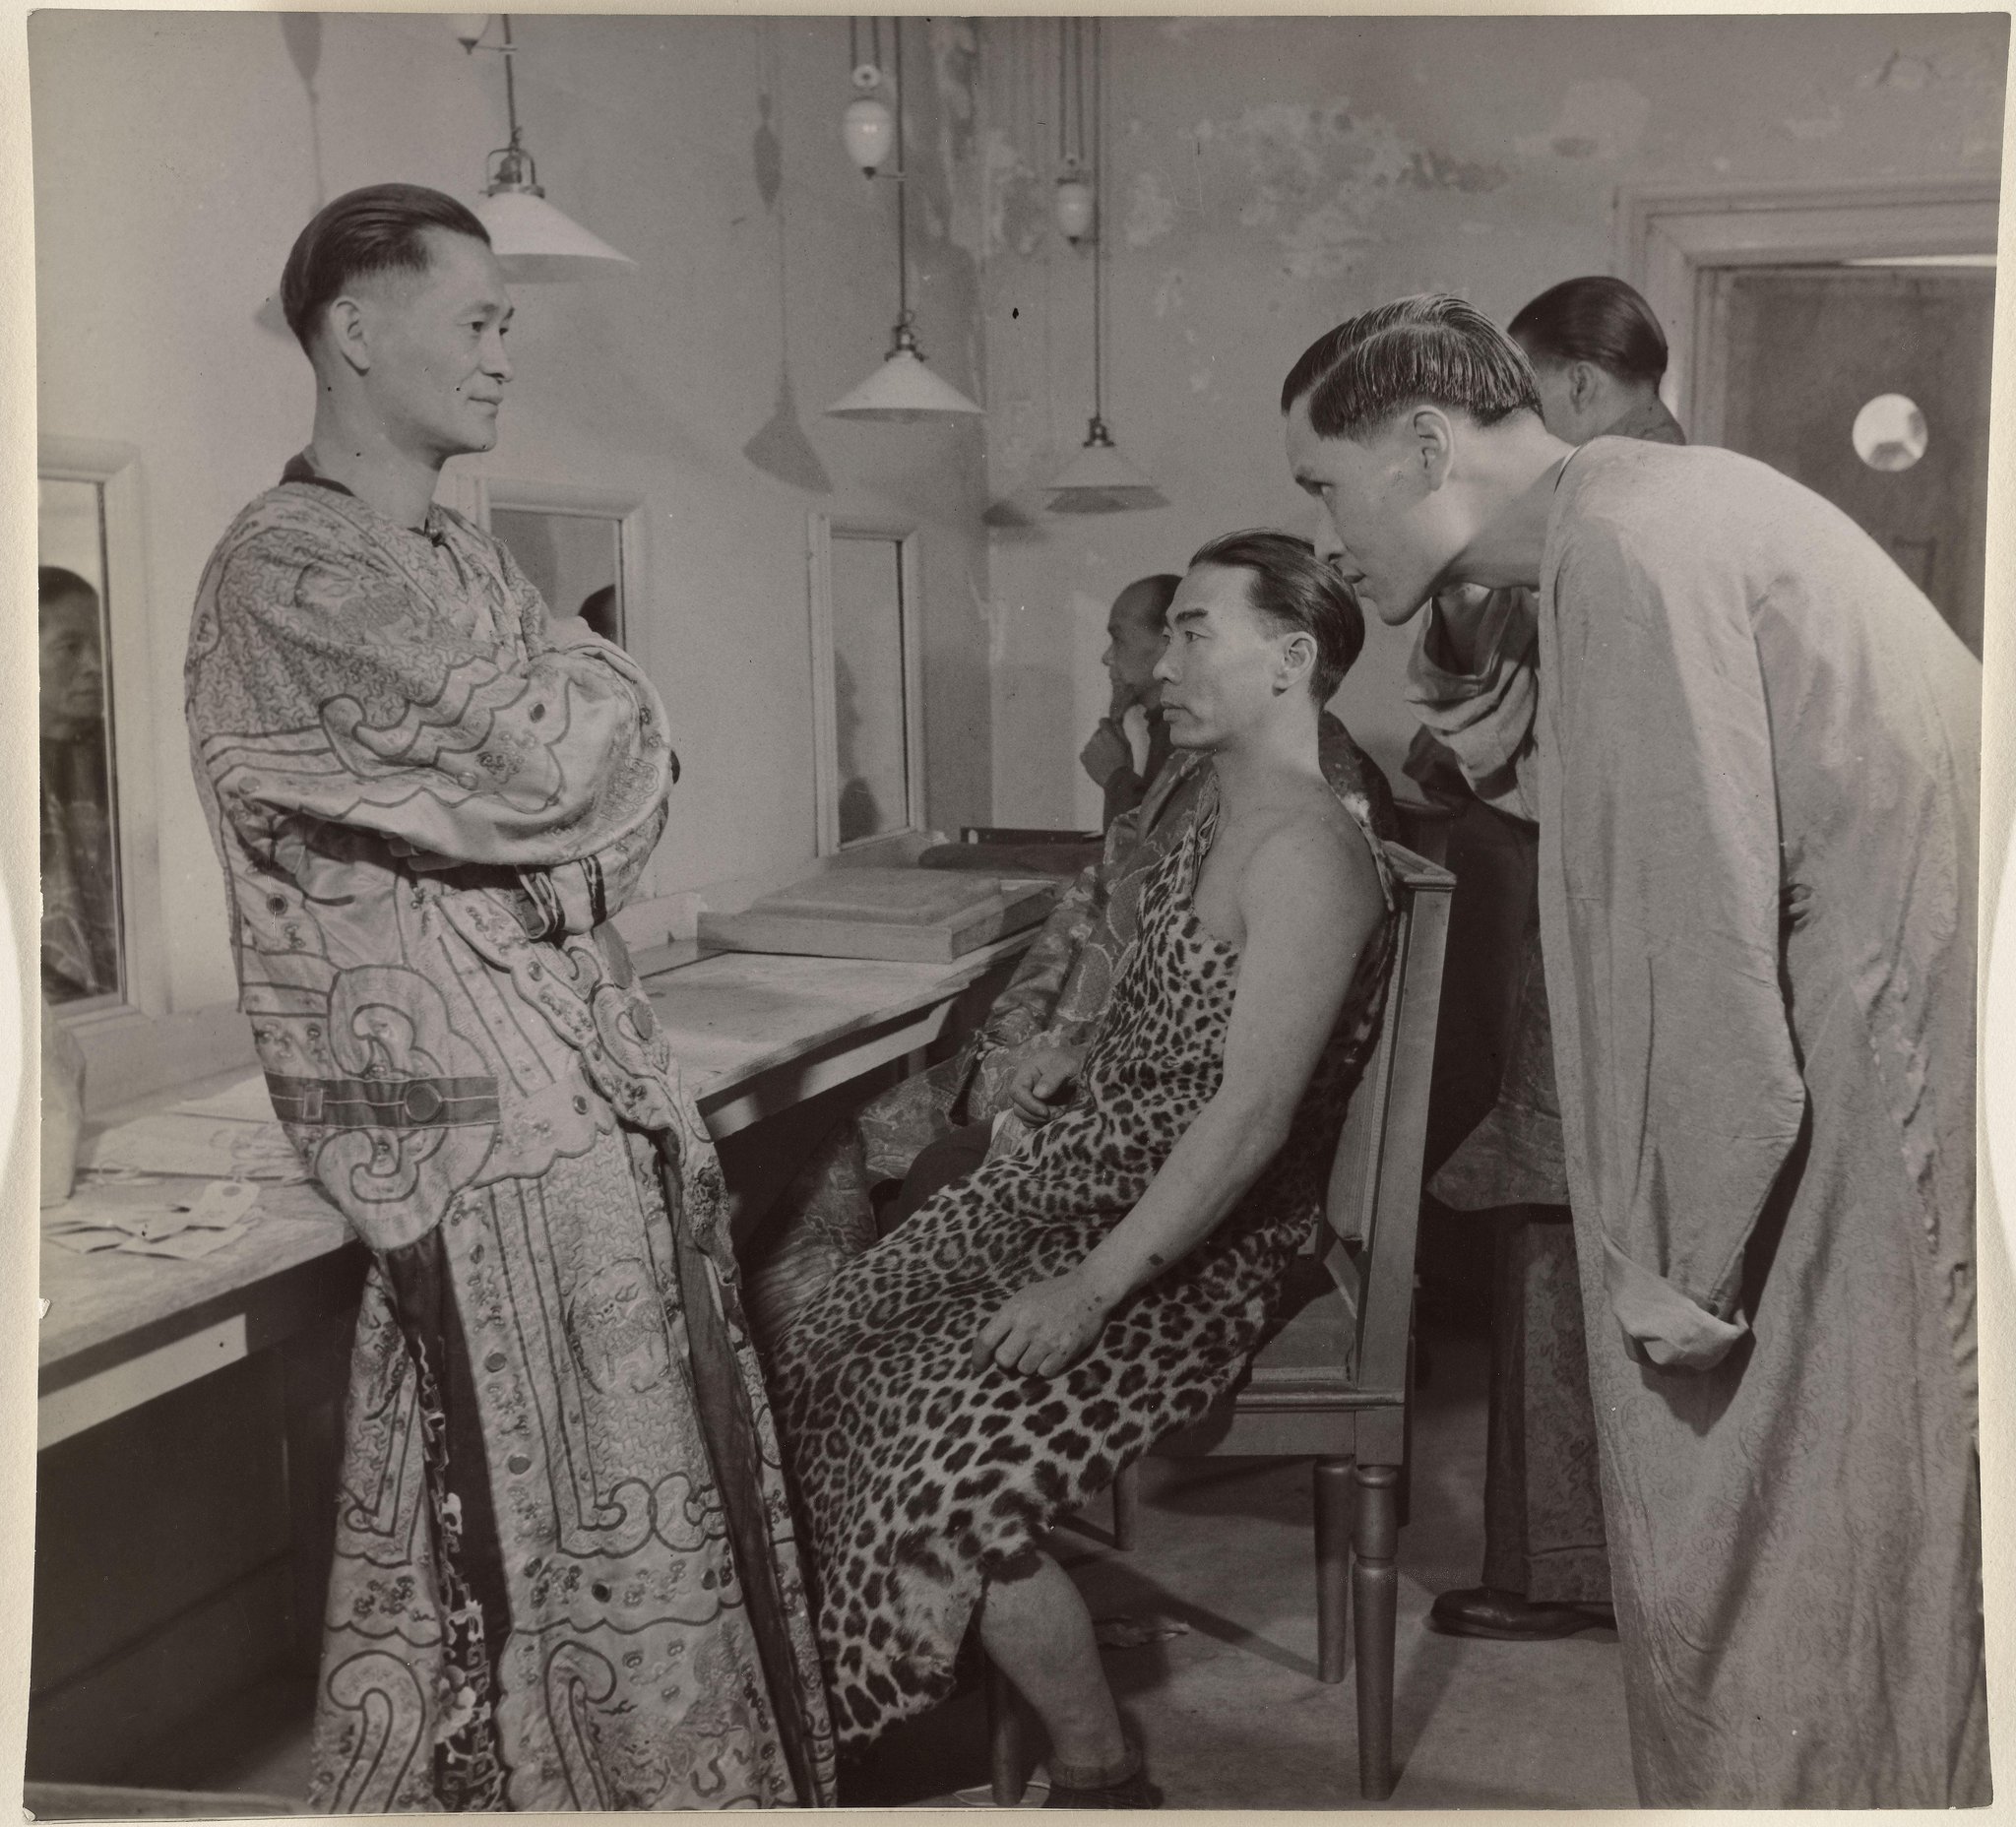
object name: photograph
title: Chinezen vieren bevrijding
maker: koos raucamp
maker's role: fotograaf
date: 1909-1945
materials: photographic support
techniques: photography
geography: amsterdam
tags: amsterdam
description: Een groep Chinezen in een kleedkamer van de Stadsschouwburg. Zij bereiden zich voor op de opvoering van het drakenspel: "De draak ontwaakt" ter ere van de bevrijding van Nederland